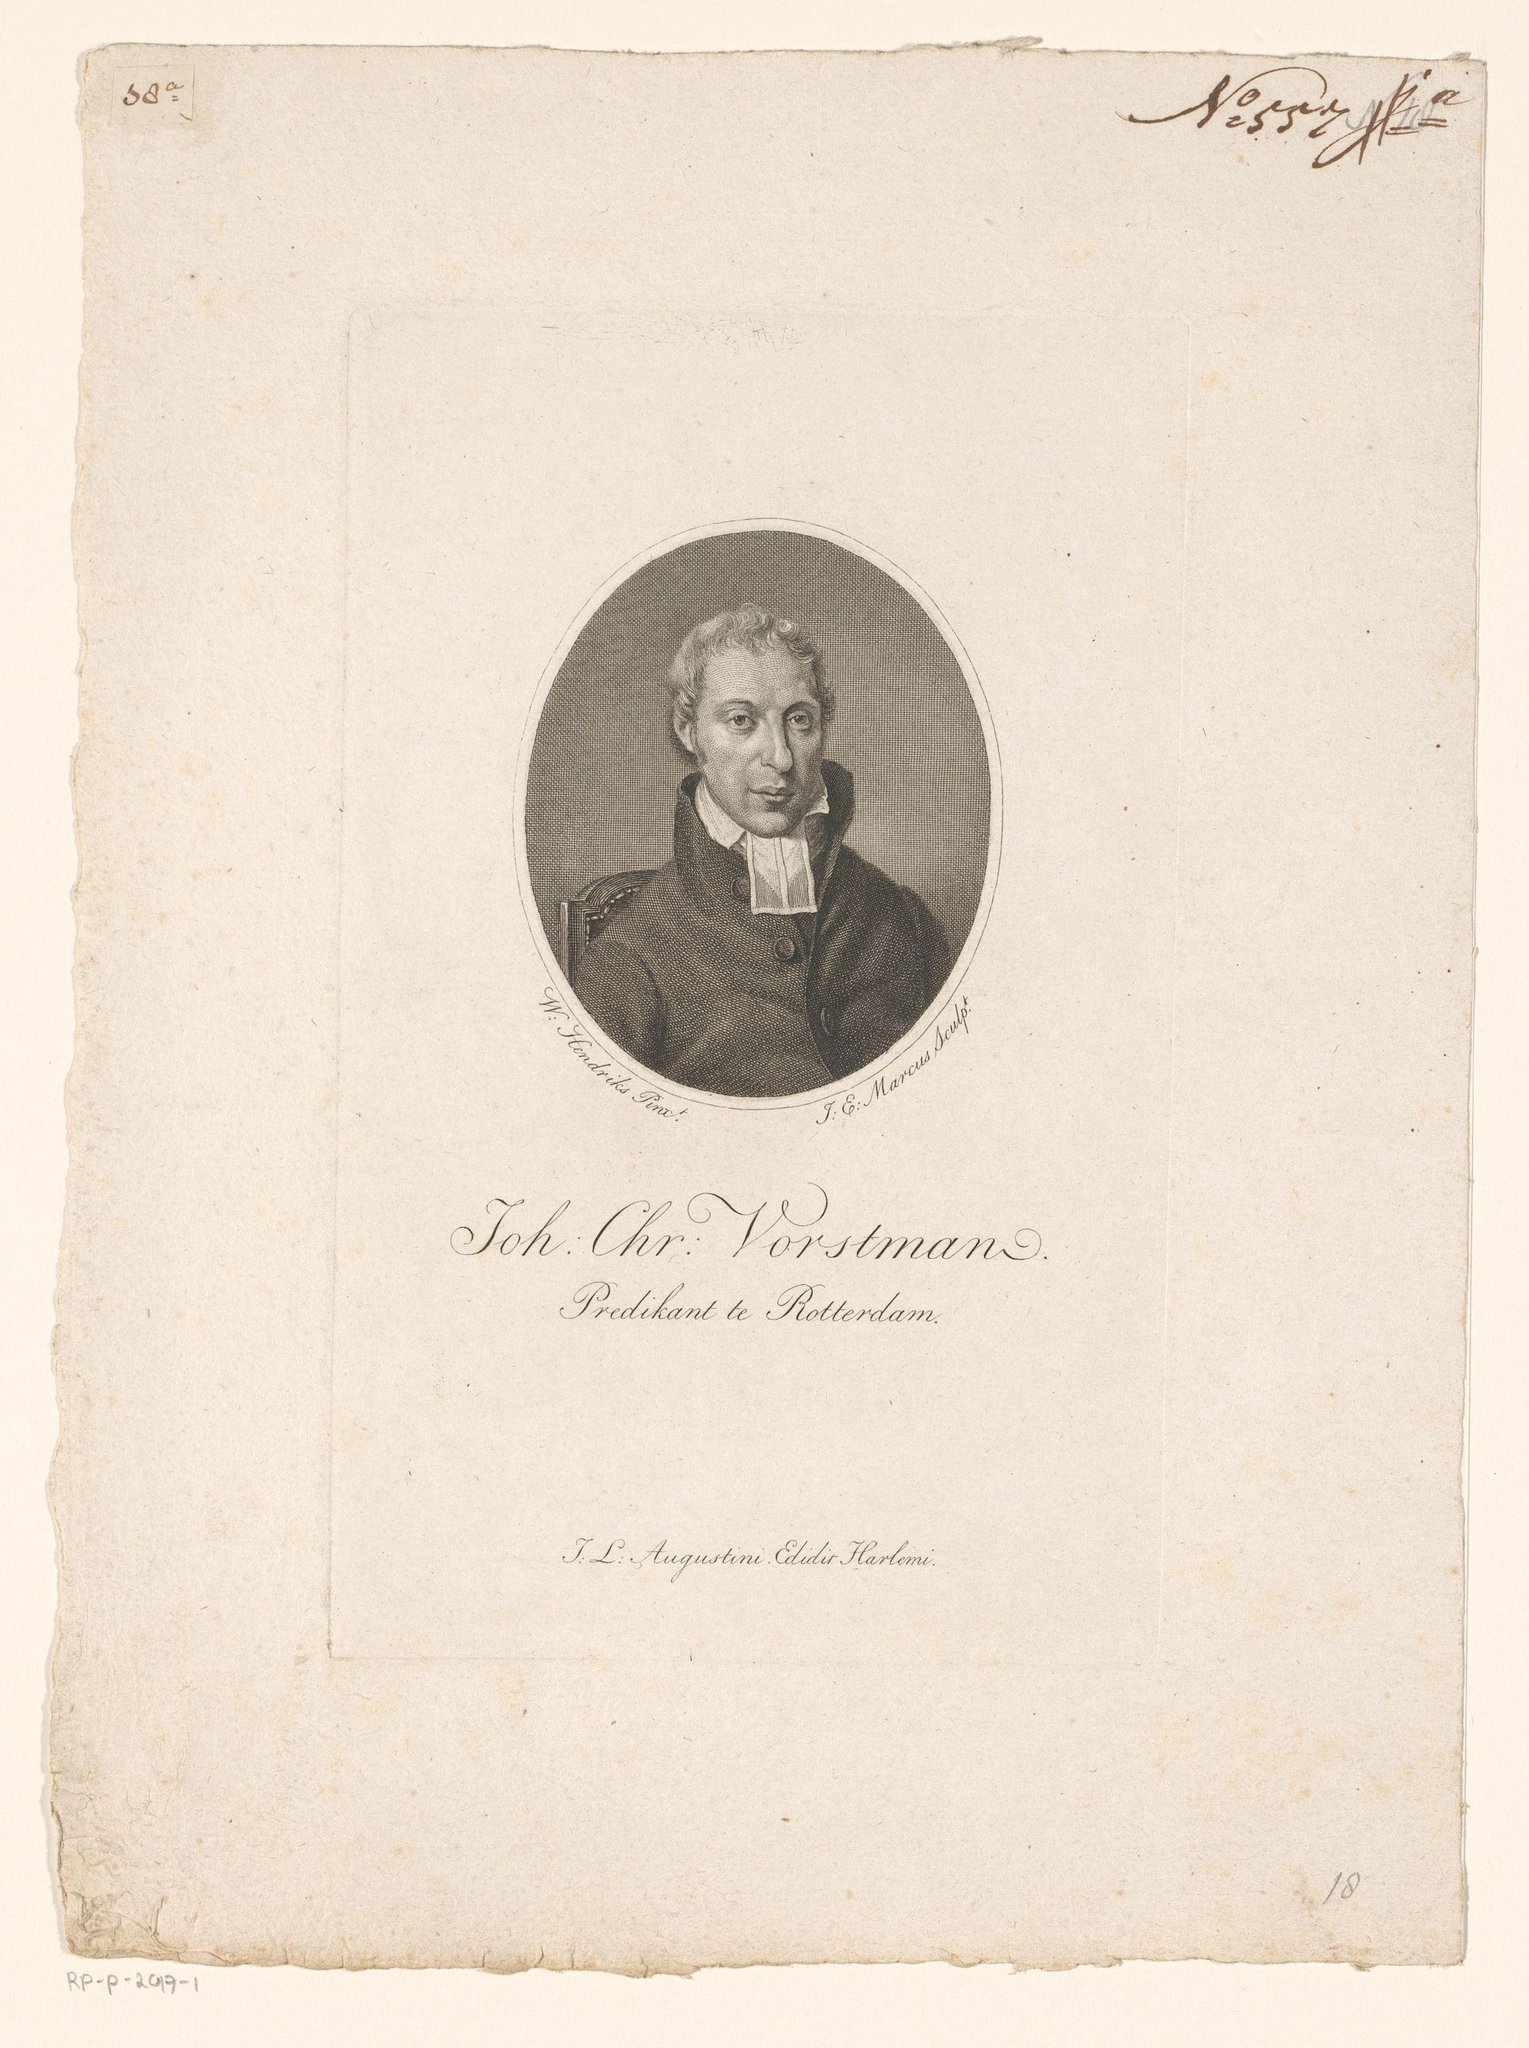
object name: print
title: Portret van Johannes Cristianus Vorstman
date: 1784-1822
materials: paper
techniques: engraving, etching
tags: historical persons (+ (full) bust portrait)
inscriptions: collector's mark: Lugt 2228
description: De geportretteerde is afgebeeld in een ovaal. Genummerd linksboven: 38a.